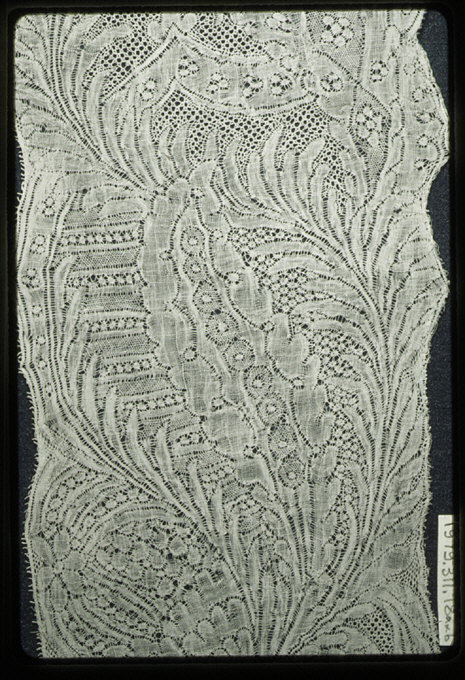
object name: lappet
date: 1667-1733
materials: linen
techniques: lace